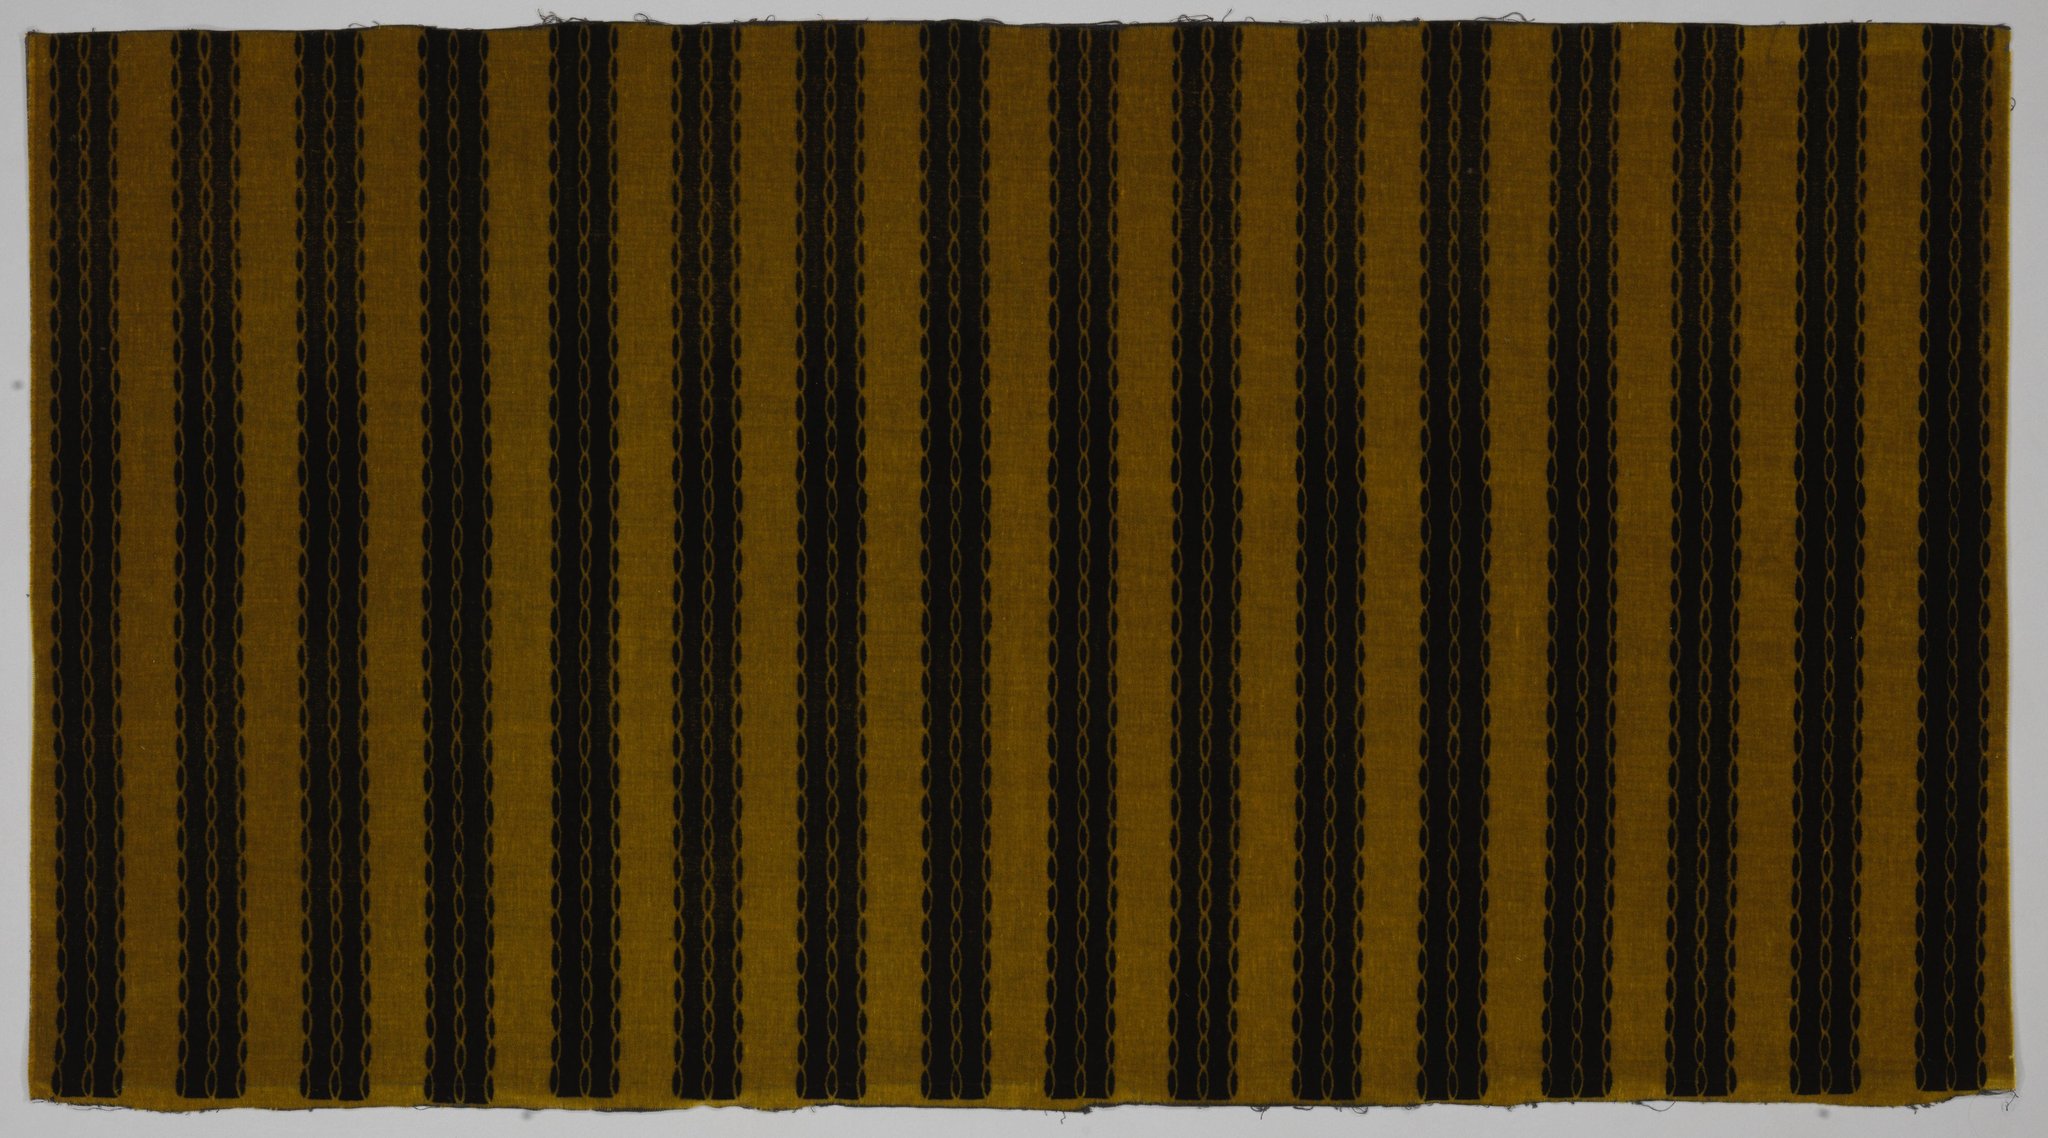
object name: bekledingsstof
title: Fragment bekledingsstof van bedrukte trijp met zwarte banden met kettingpatroon op een olijfgroene grond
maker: Anonymous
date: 1910-1920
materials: cotton, textile, hair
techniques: printing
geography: netherlands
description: Fragment bekledingsstof van bedrukte trijp. Op een olijfgroene grond lopen zwarte banden met kettingpatroon. Trijpgeweven met een v-binding.